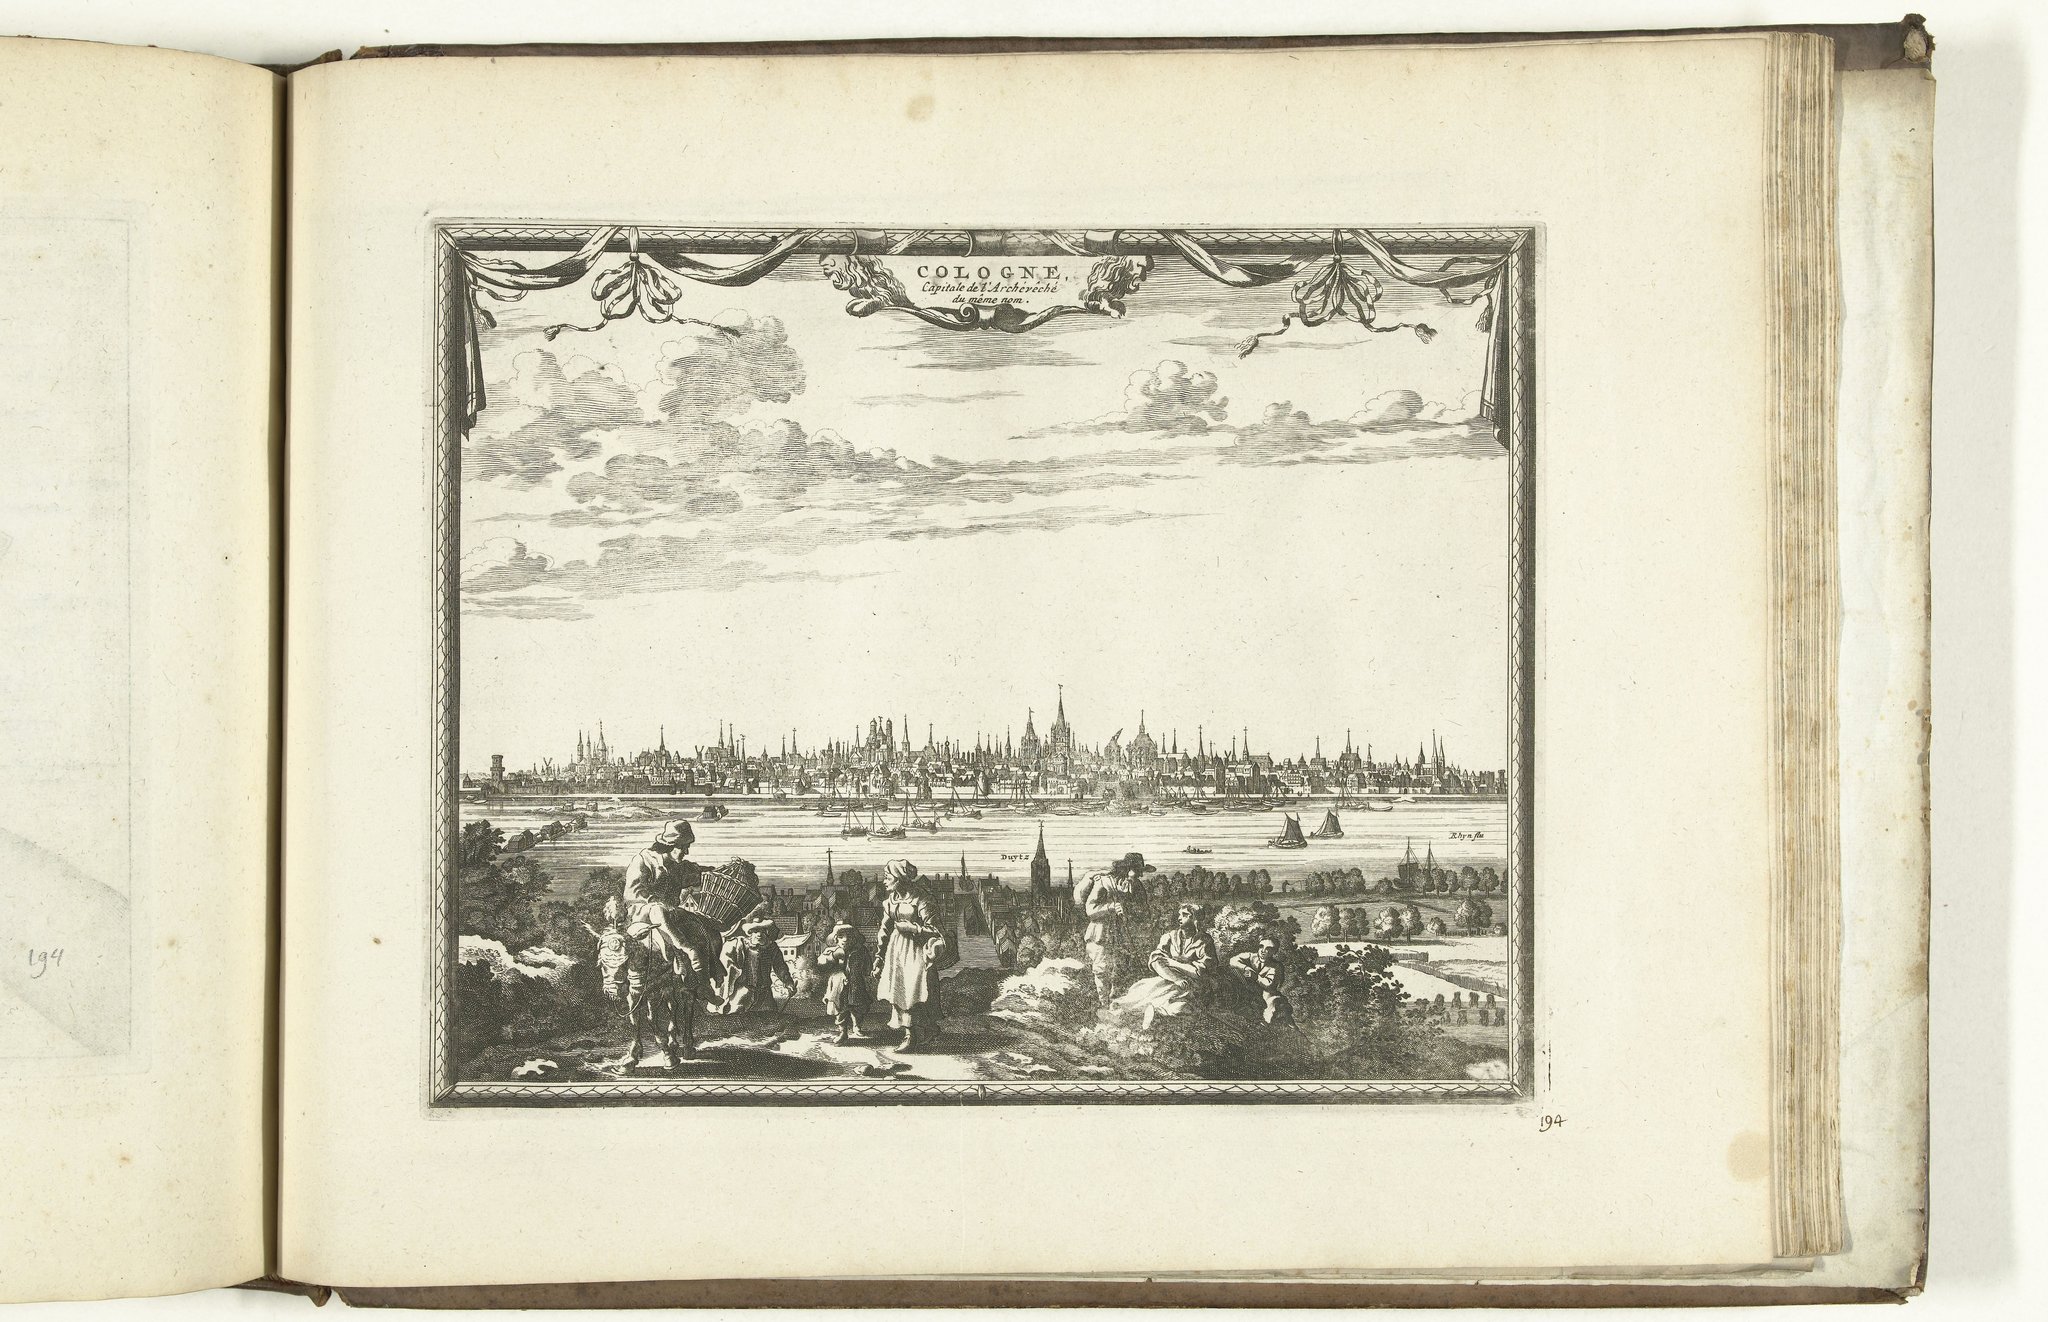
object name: print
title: Cologne, Capitale de l'Arcévêché du même nom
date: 1726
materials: paper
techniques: etching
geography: leiden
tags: cologne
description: Gezicht op Keulen, op de voorgrond reizigers. Plaat nr. 194 in deel VIII van het prentwerk: Les Forces de l'Europe, Asie, Afrique et Amerique ... Comme aussi les Cartes des Côtes de France et d'Espagne uit 1726, dit eerste deel met 238 met de hand genummerde platen van vermaarde sterke steden en vestingen in het kader van de Spaanse Successieoorlog 1701-1713. Voor het merendeel zijn deze platen gekopieerd naar de anonieme Franse platen van vermaarde sterke steden en vestingen: in Les forces de l'Europe en in: Le theatre de la guerre, dans les Pays-Bas, beide oorspronkelijk uitgegeven door Nicolas de Fer te Parijs (1693-1697) in het kader van de Negenjarige Oorlog. Titel in het Frans.